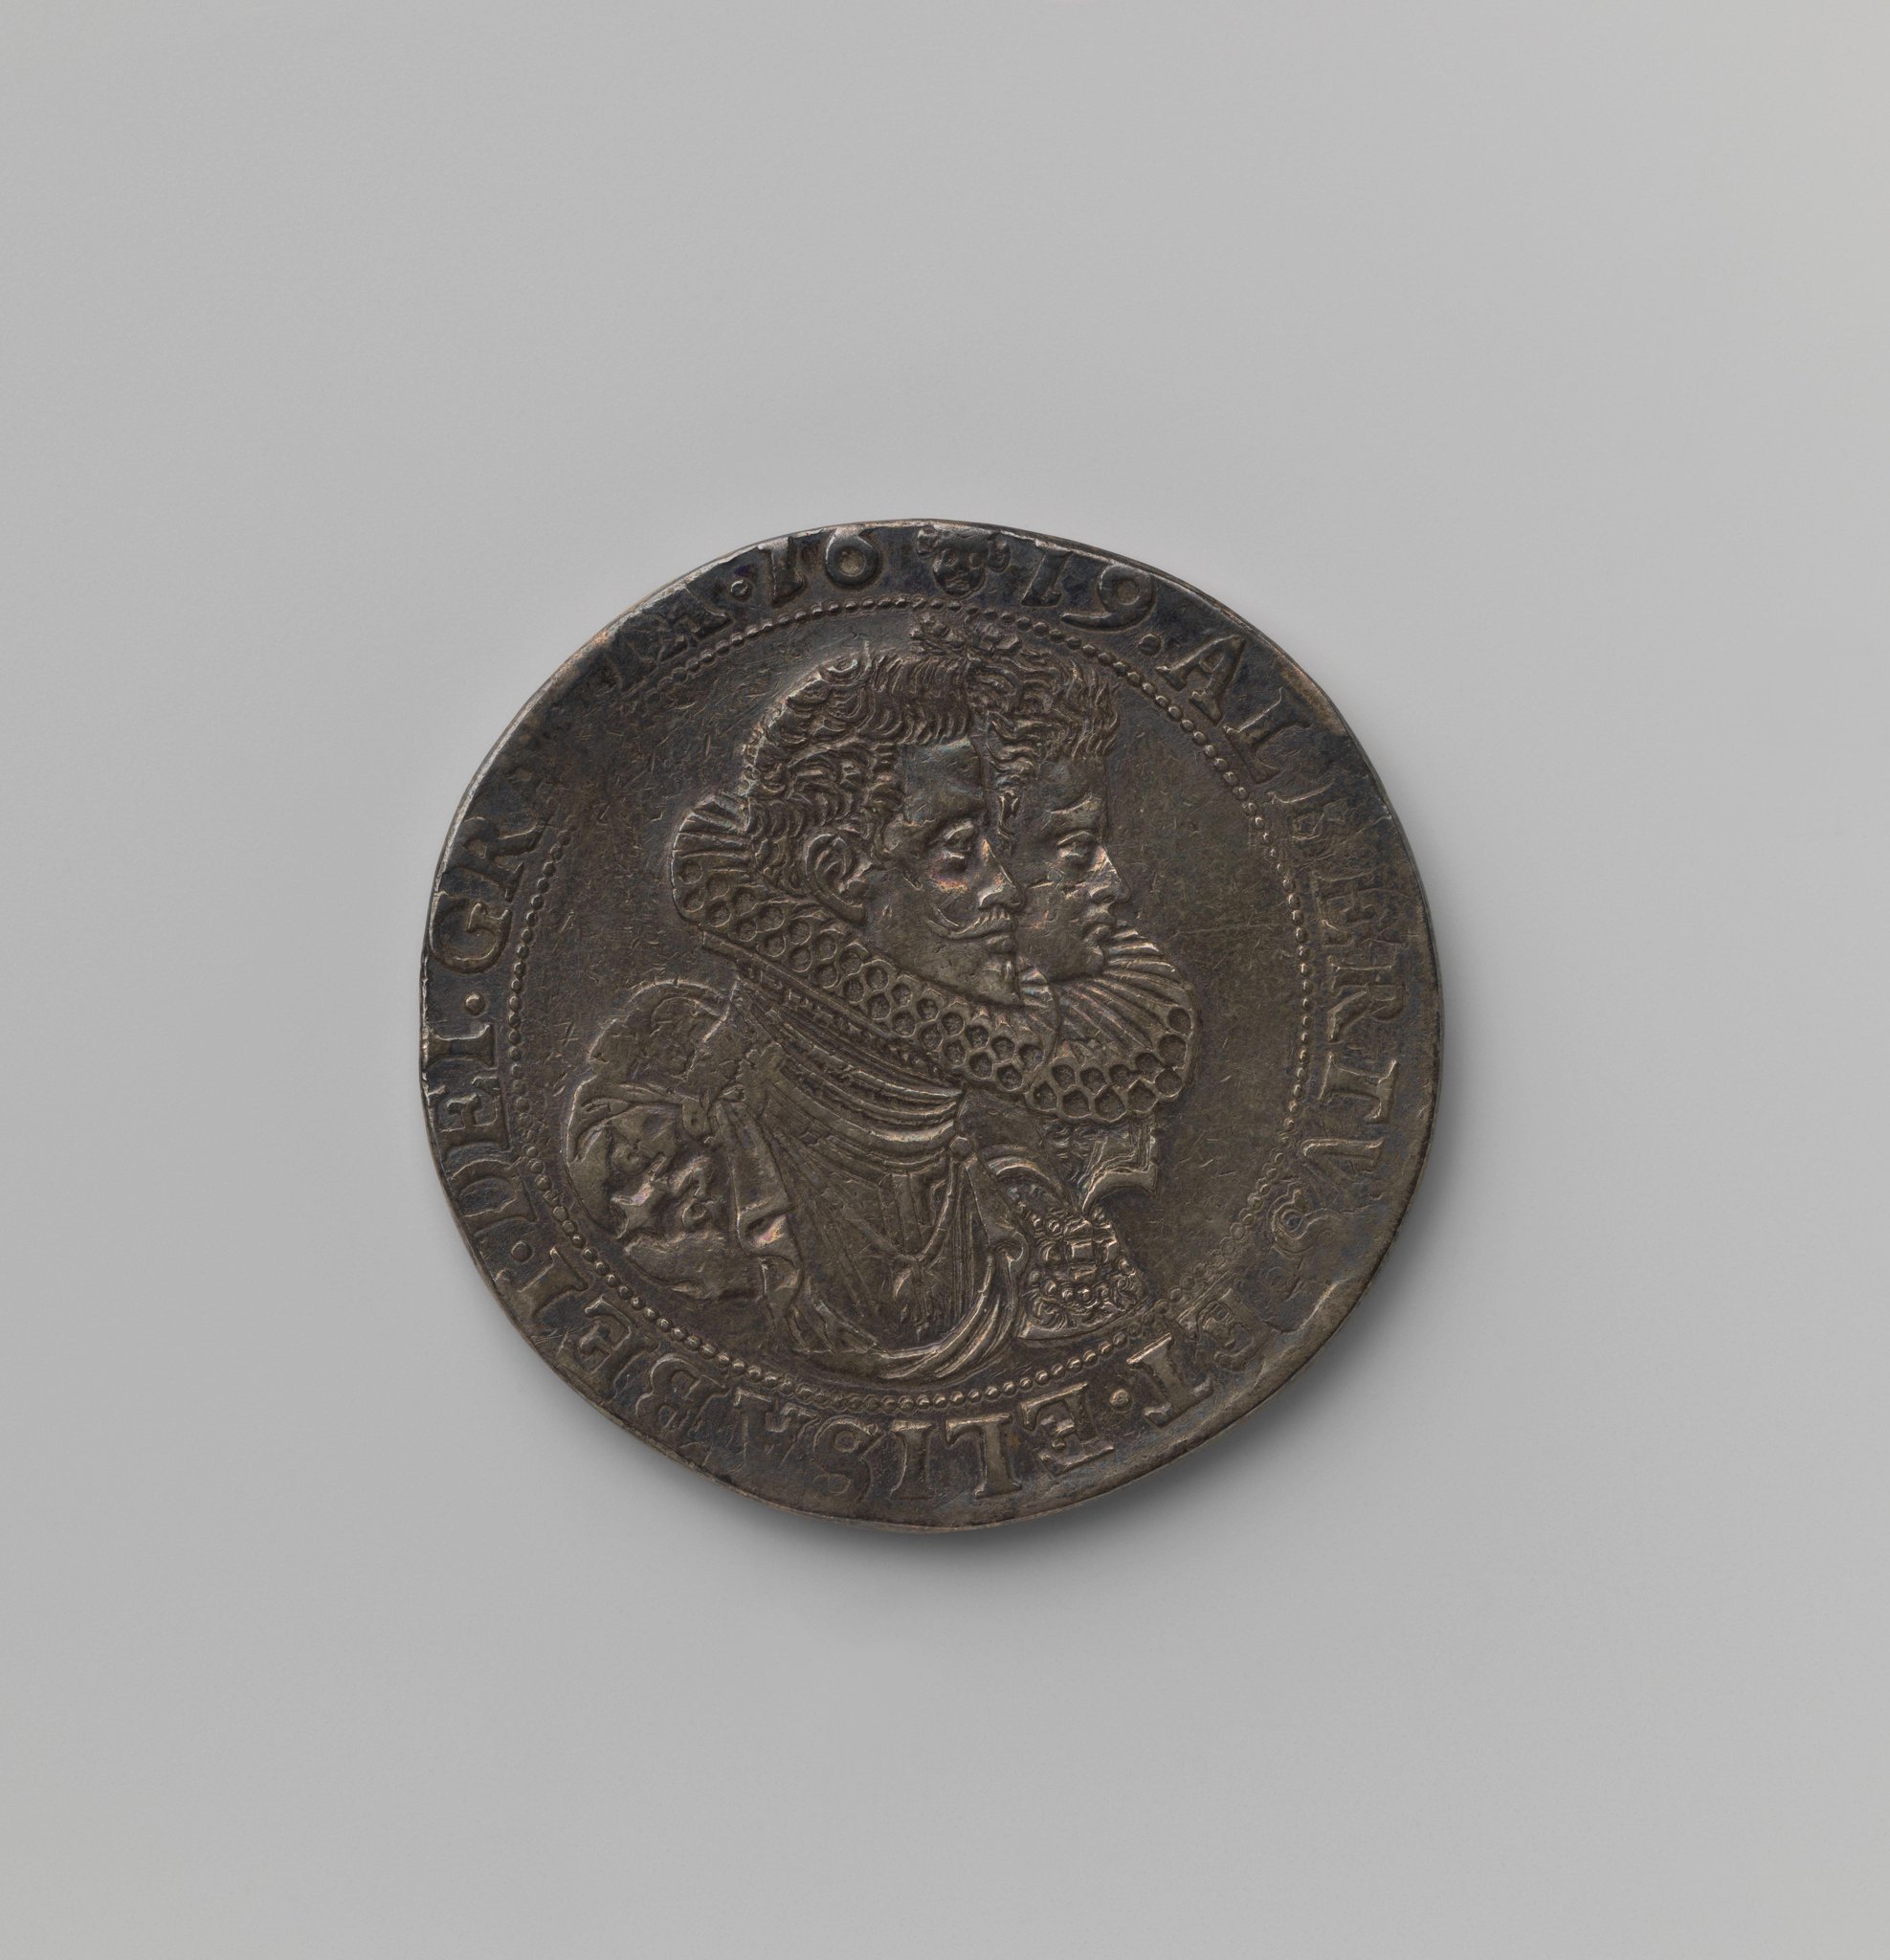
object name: coin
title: Brabant, Albert en Isabella, dukaton, 1619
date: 1619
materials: silver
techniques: striking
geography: brussels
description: Zilveren munt. Voorzijde: portretten van Albert en Isabella naar rechts. Jaartal, waartussen engelenkopje, in omschrift. Keerzijde: door twee leeuwen gehouden gekroond samengesteld wapenschild. Onder wapenschild twee naar elkaar gekeerde vuurijzers met vonken, waaronder gulden vlies.